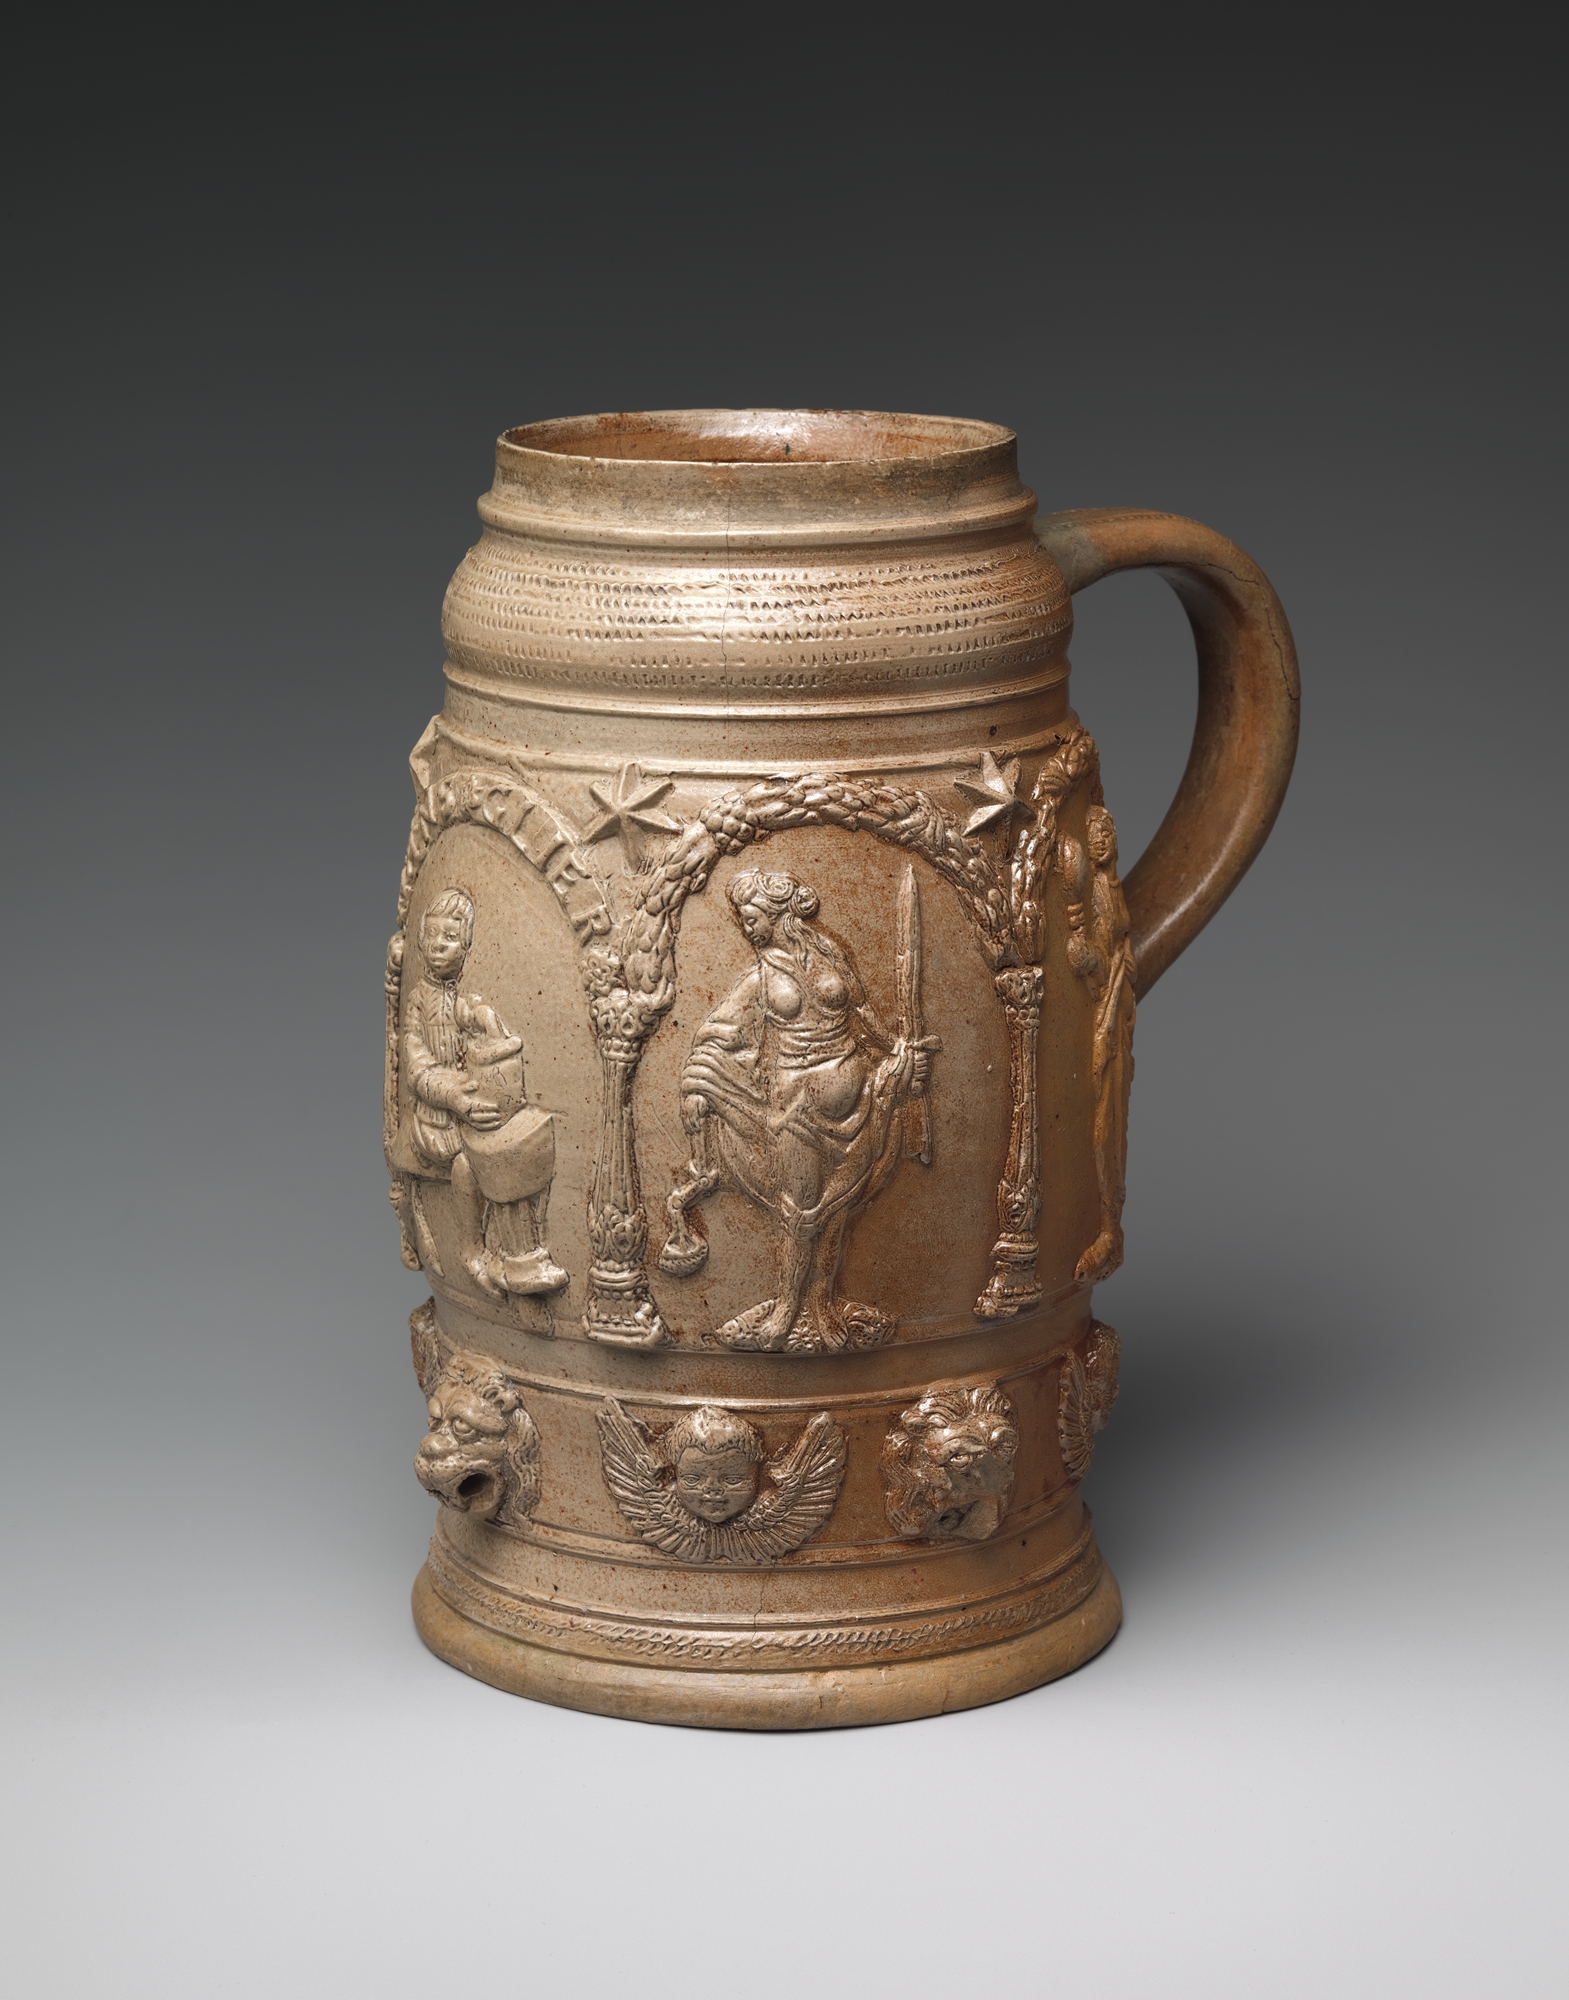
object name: tankard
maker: hans glier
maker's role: maker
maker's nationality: german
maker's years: 1550-1650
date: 1560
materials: stoneware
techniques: salt glaze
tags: faces,women,lions